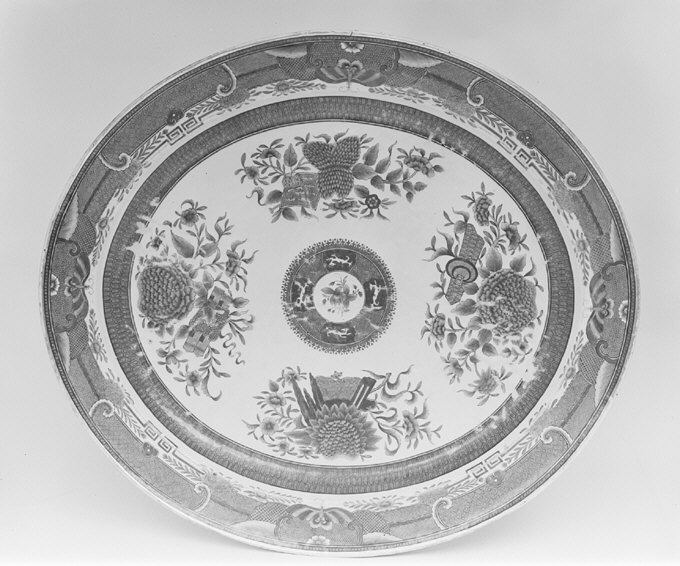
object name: platter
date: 1801-1833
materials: hard paste porcelain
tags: flowers